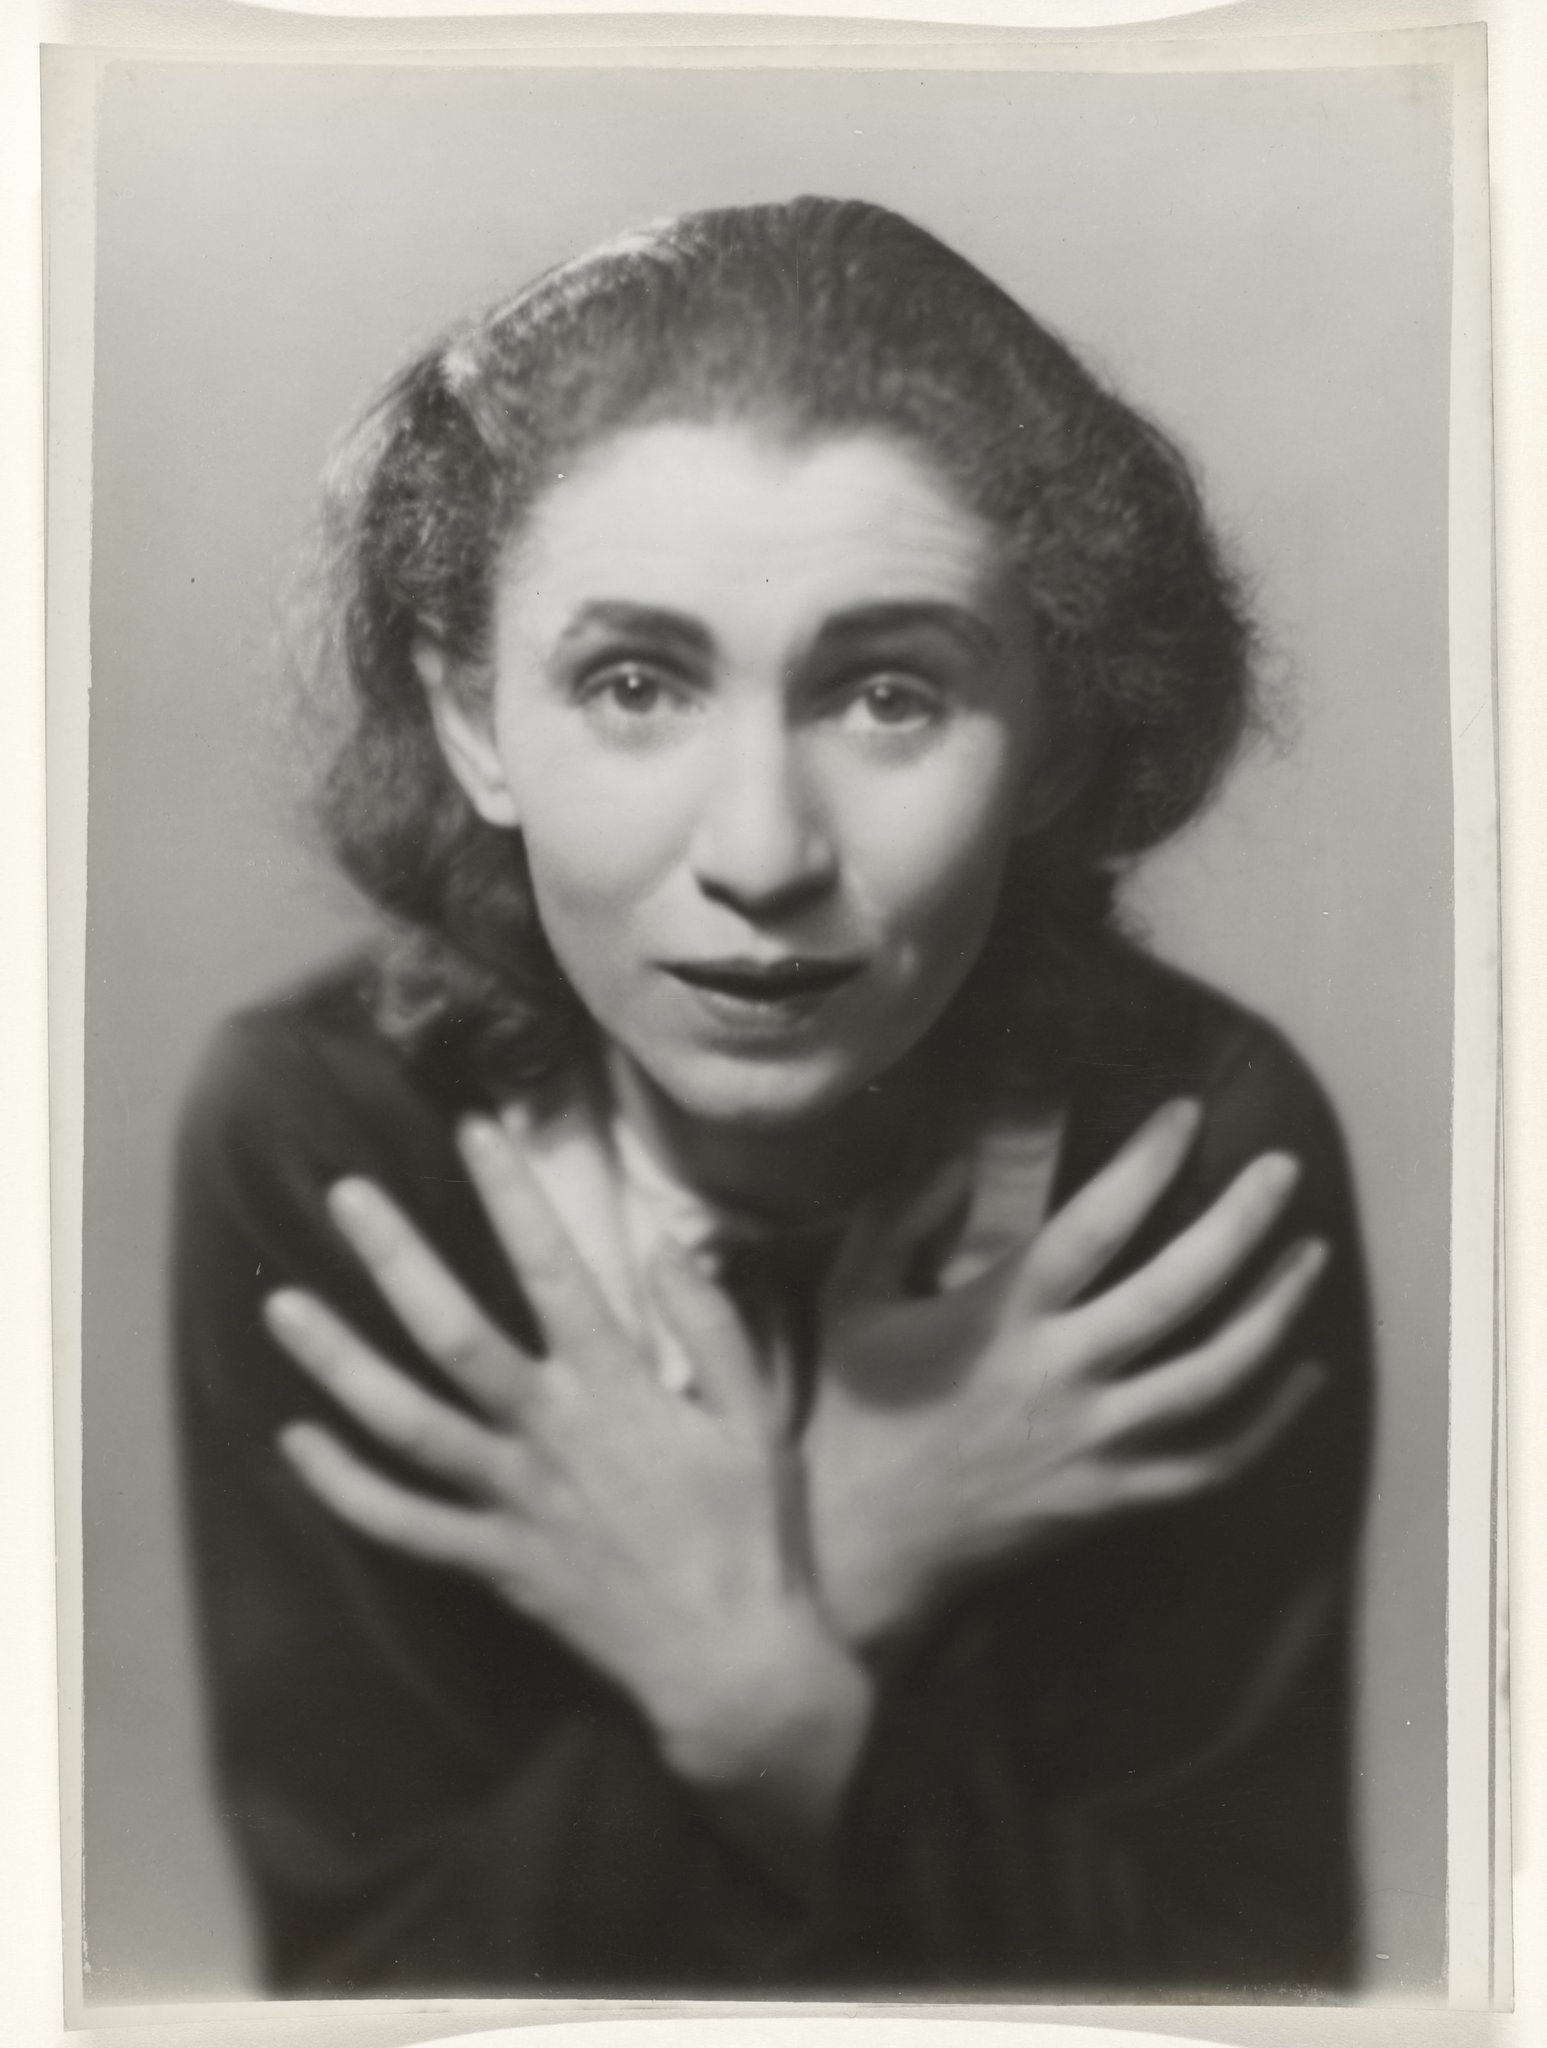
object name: photograph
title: Chaja Goldstein tijdens toneelspel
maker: jacob merkelbach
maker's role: fotograaf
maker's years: 1877-1942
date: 1930-1960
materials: photographic support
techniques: gelatin silver print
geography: amsterdam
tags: historical persons - bb - woman, female dancer, amsterdam